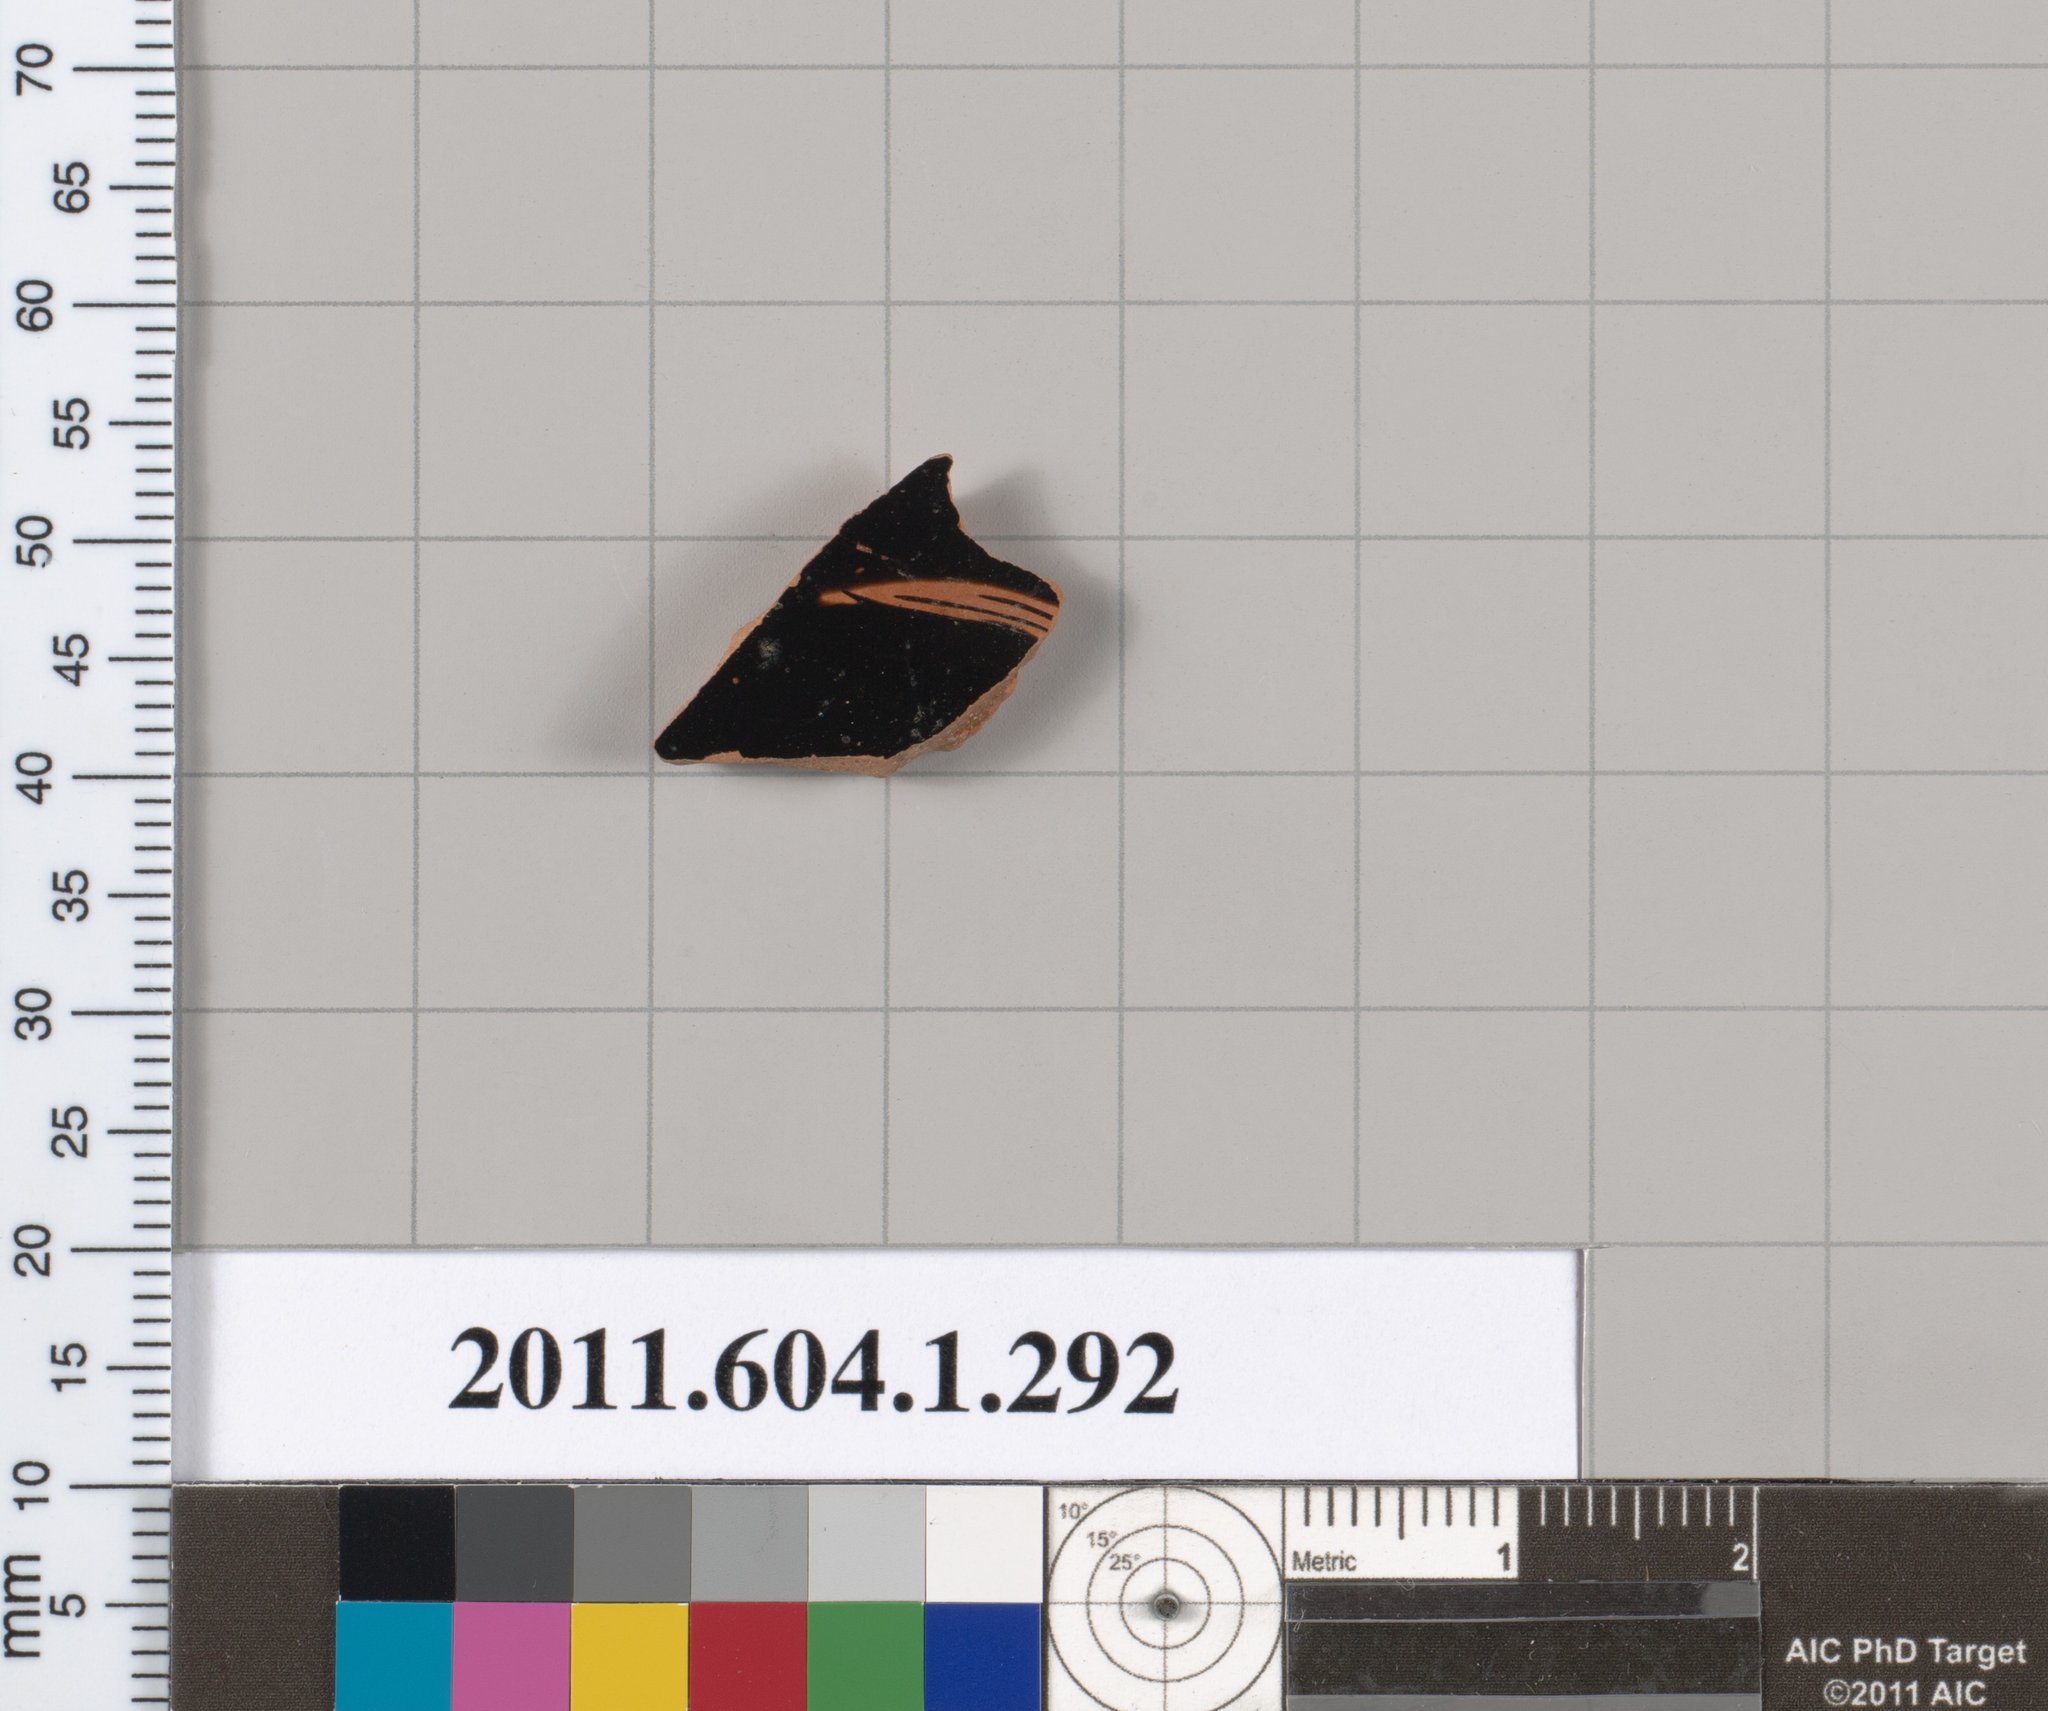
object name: kylix fragment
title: Terracotta fragment of a kylix (drinking cup)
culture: greek, attic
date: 475-451 BCE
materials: terracotta